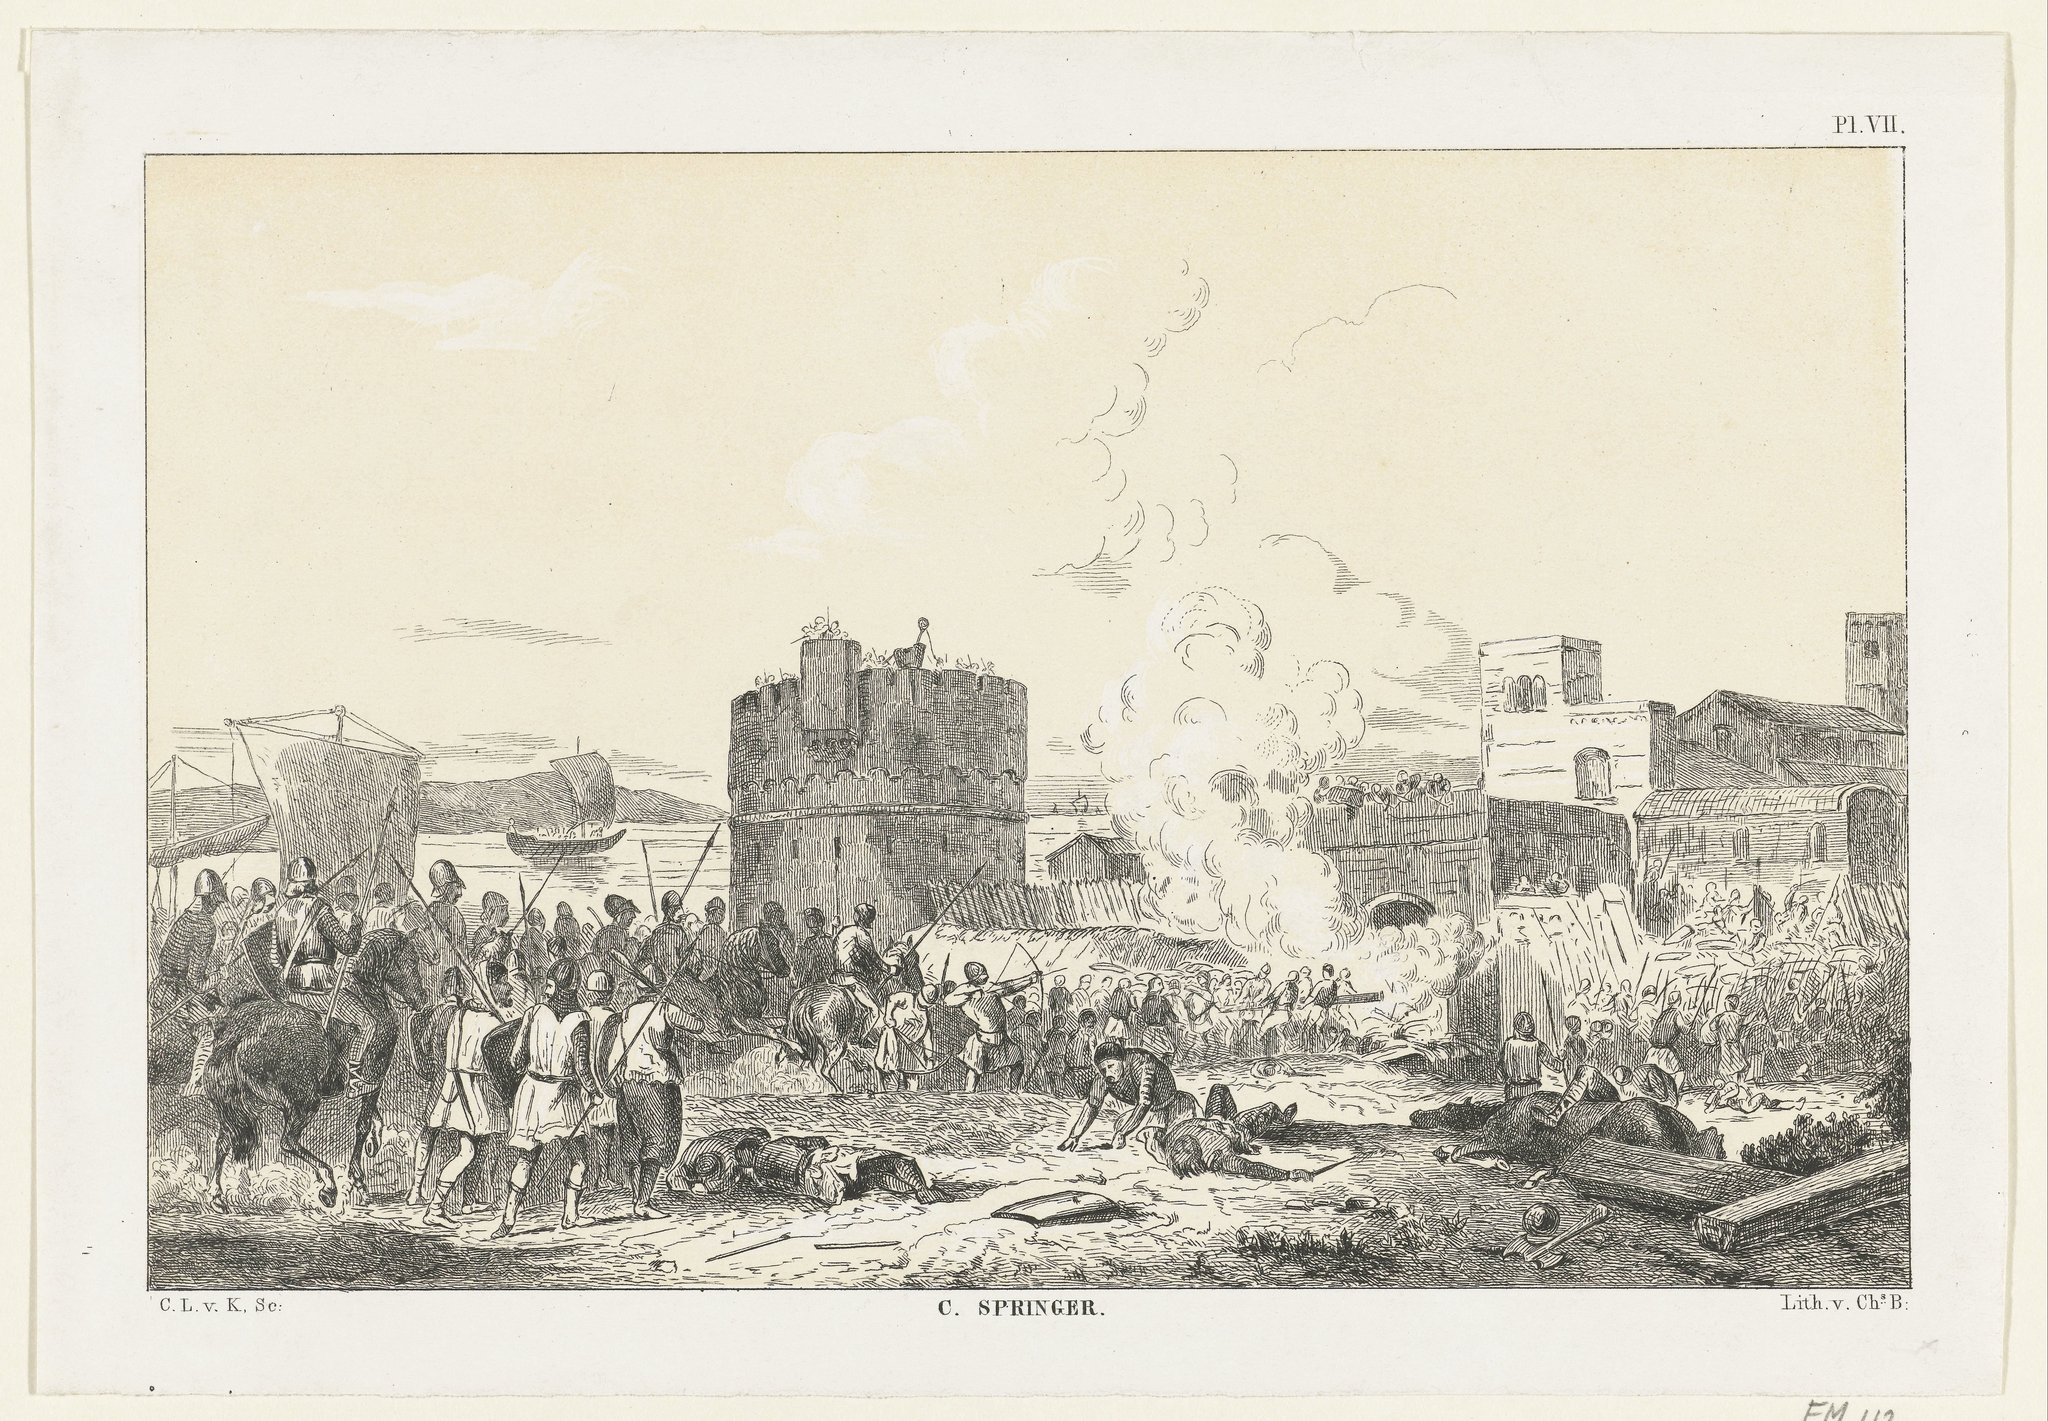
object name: print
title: Aanval door Noormannen op een rivierstad in Nederland, 9e eeuw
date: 1853-1861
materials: paper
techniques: lithograph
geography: netherlands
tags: siege, position war, extinct, 'historical' peoples (with name), netherlands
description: Illustratie voor: Jacob van Lennep, De geschiedenis des vaderlands in schetsen en afbeeldingen, Binger, Amsterdam 1855-1861, 8 delen, pl. VII.